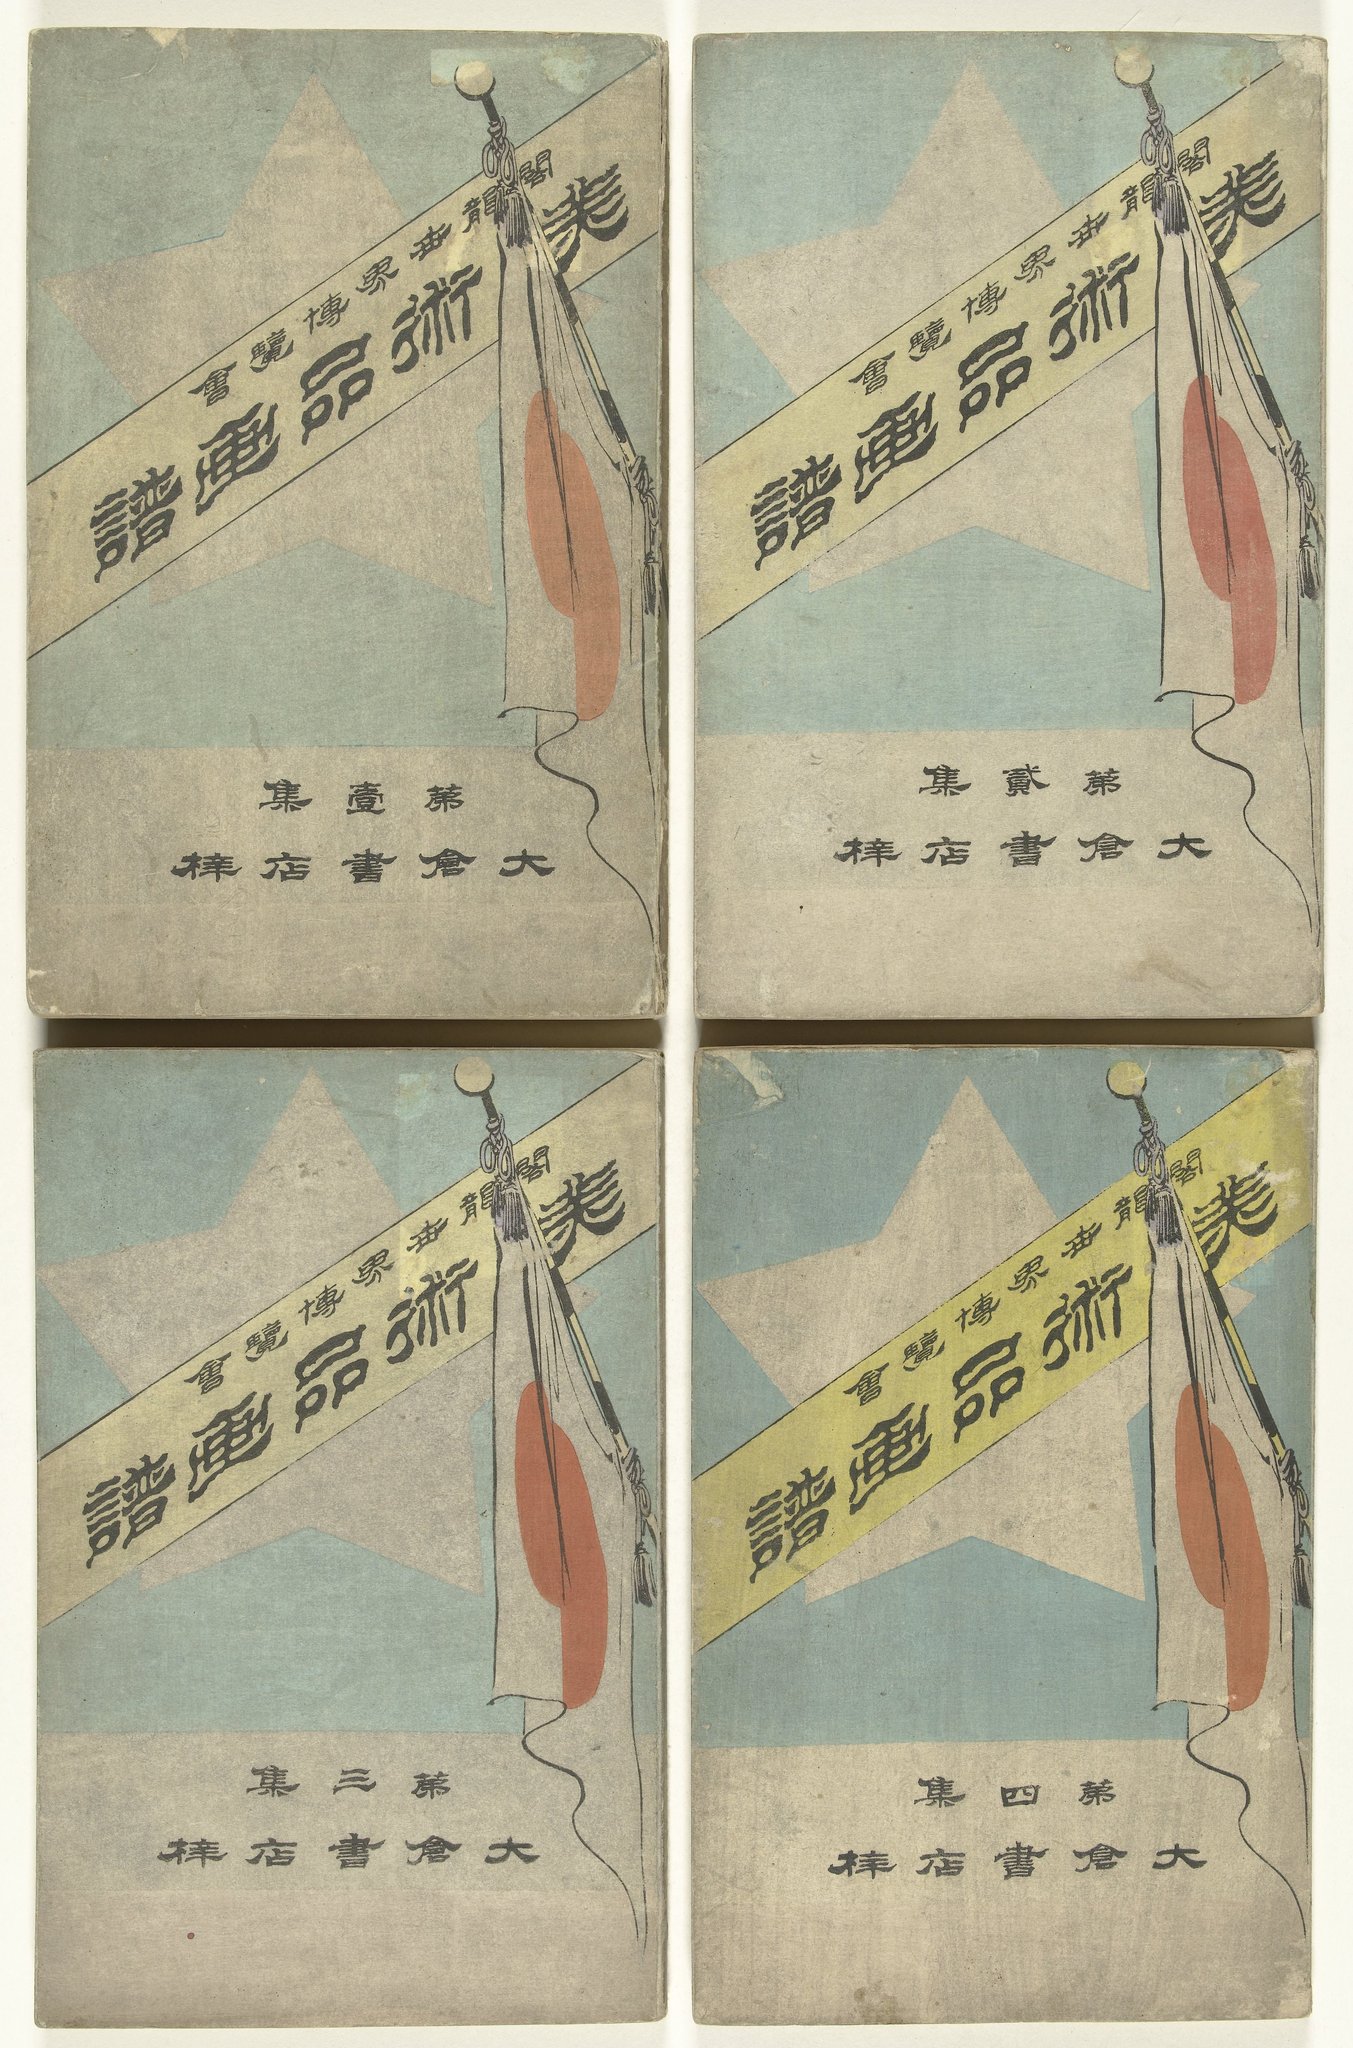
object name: book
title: World`s Columbian exposition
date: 1893-1894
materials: paper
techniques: woodcut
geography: japan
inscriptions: date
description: Vier delen (compleet) met afbeeldingen van het Japanse paviljoen en tentoongestelde werken op de wereldtentoonstelling in Chicago in 1893.